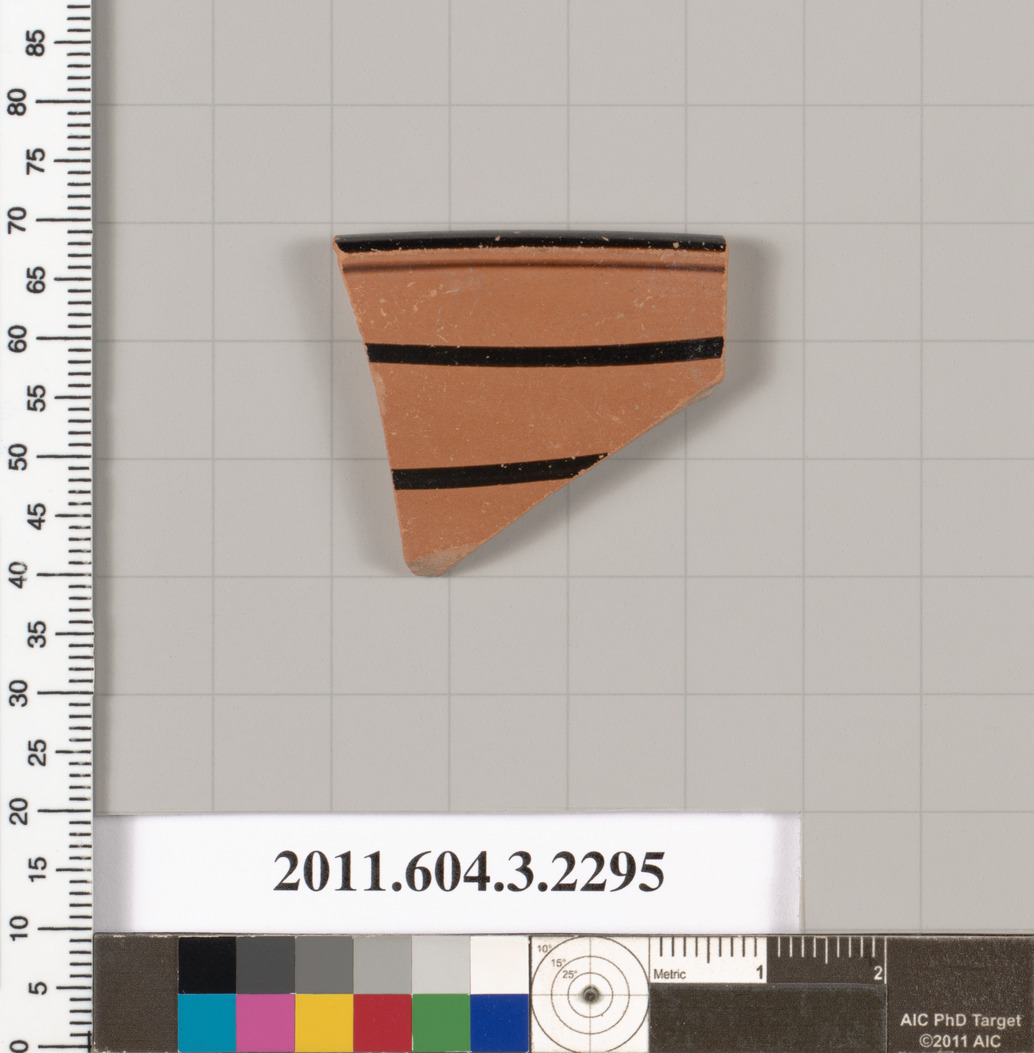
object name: kylix fragment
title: Terracotta rim fragment of a kylix: eye-cup (drinking cup)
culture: greek, attic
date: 540-500 BCE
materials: terracotta